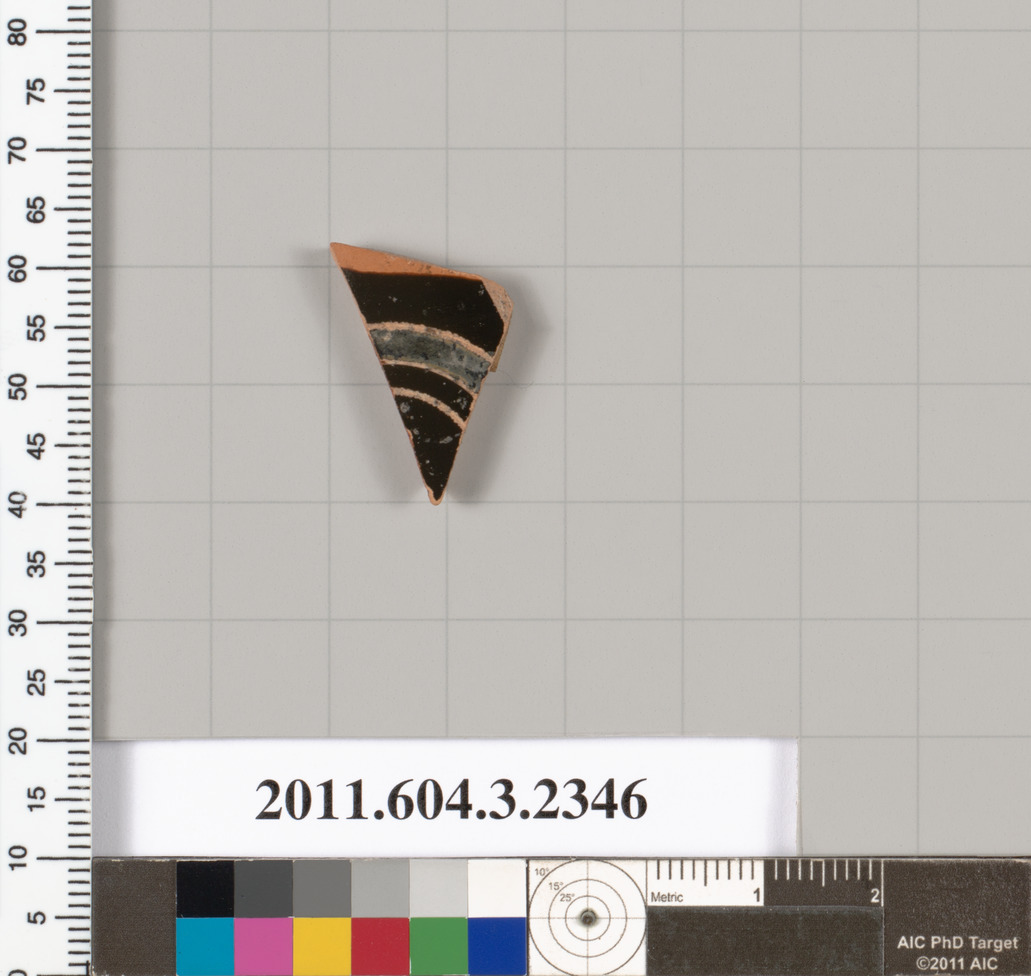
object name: kylix fragment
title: Terracotta fragment of a kylix: eye-cup (drinking cup)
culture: greek, attic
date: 540-520 BCE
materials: terracotta